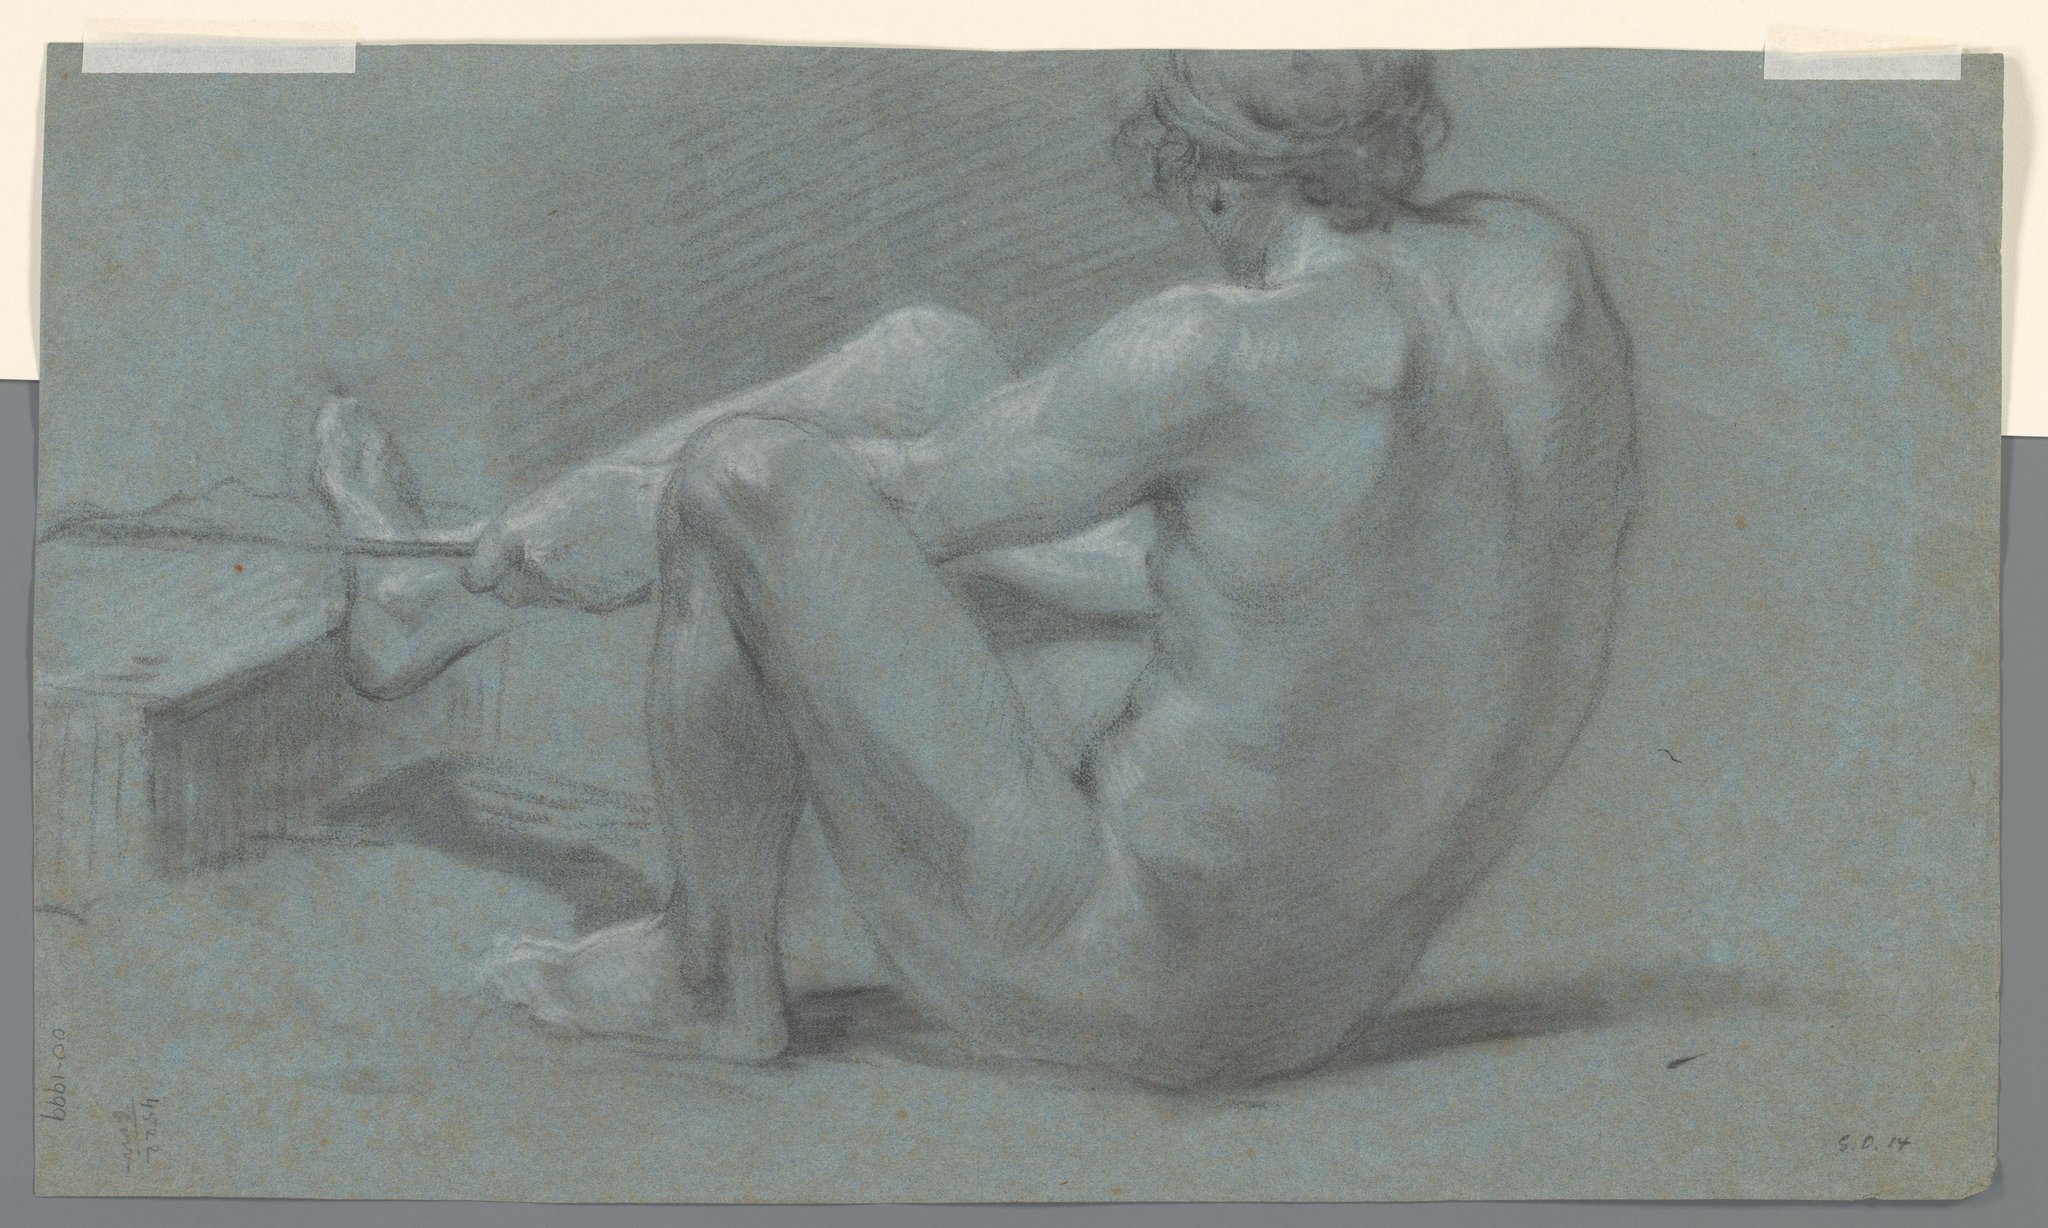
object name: drawing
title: Zittend mannelijk naakt, naar links, trekkend en zich afzettend tegen een blok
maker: Anonymous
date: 1797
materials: chalk, paper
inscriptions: date: ‘18 feb 1797’